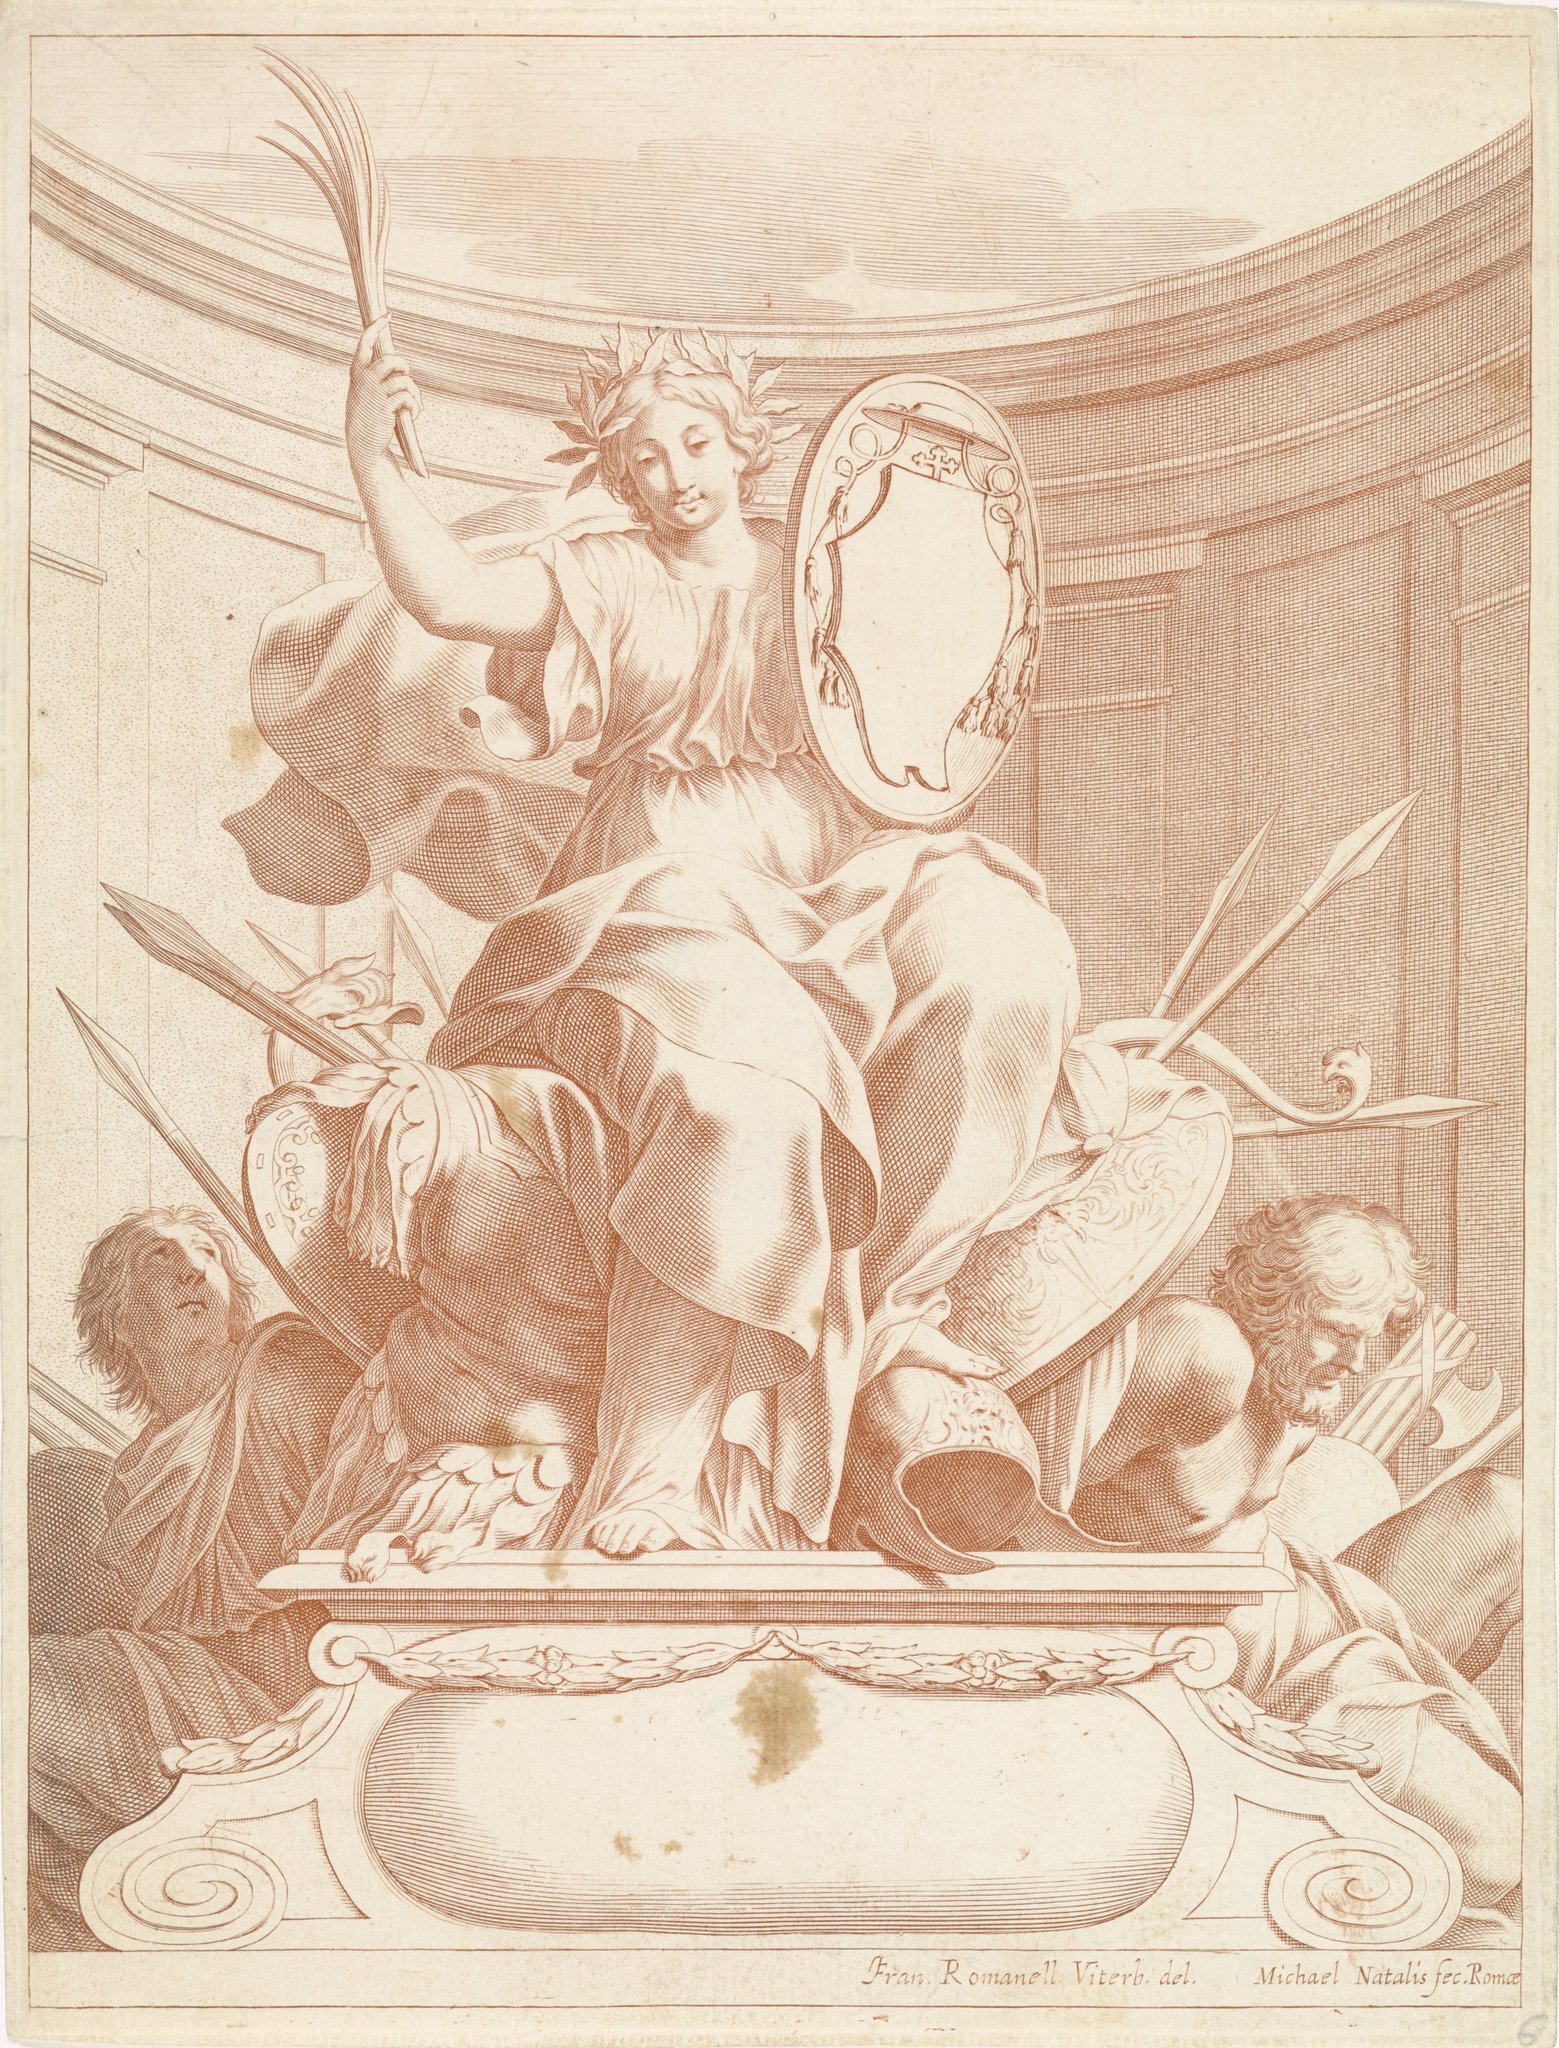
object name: print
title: Overwinning van de familie Barberini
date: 1632-1633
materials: paper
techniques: printing, engraving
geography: rome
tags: victory (+ personification), weapons, armorial bearing, heraldry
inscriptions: collector's mark: Lugt 2228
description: De Overwinning houdt een palmtak in de hand en houdt een wapenschild op, dat gekroond is met de kardinaalshoed. Zij zit op schilden, wapens en borstkurassen. Aan weerszijden zitten twee mannen. Het wapenschild is leeg, maar op grond van een door Renier beschreven staat, verbeeldt deze voorstelling het succes van de Romeinse familie Barberini. Paus Urbanus VIII kwam uit hun midden.